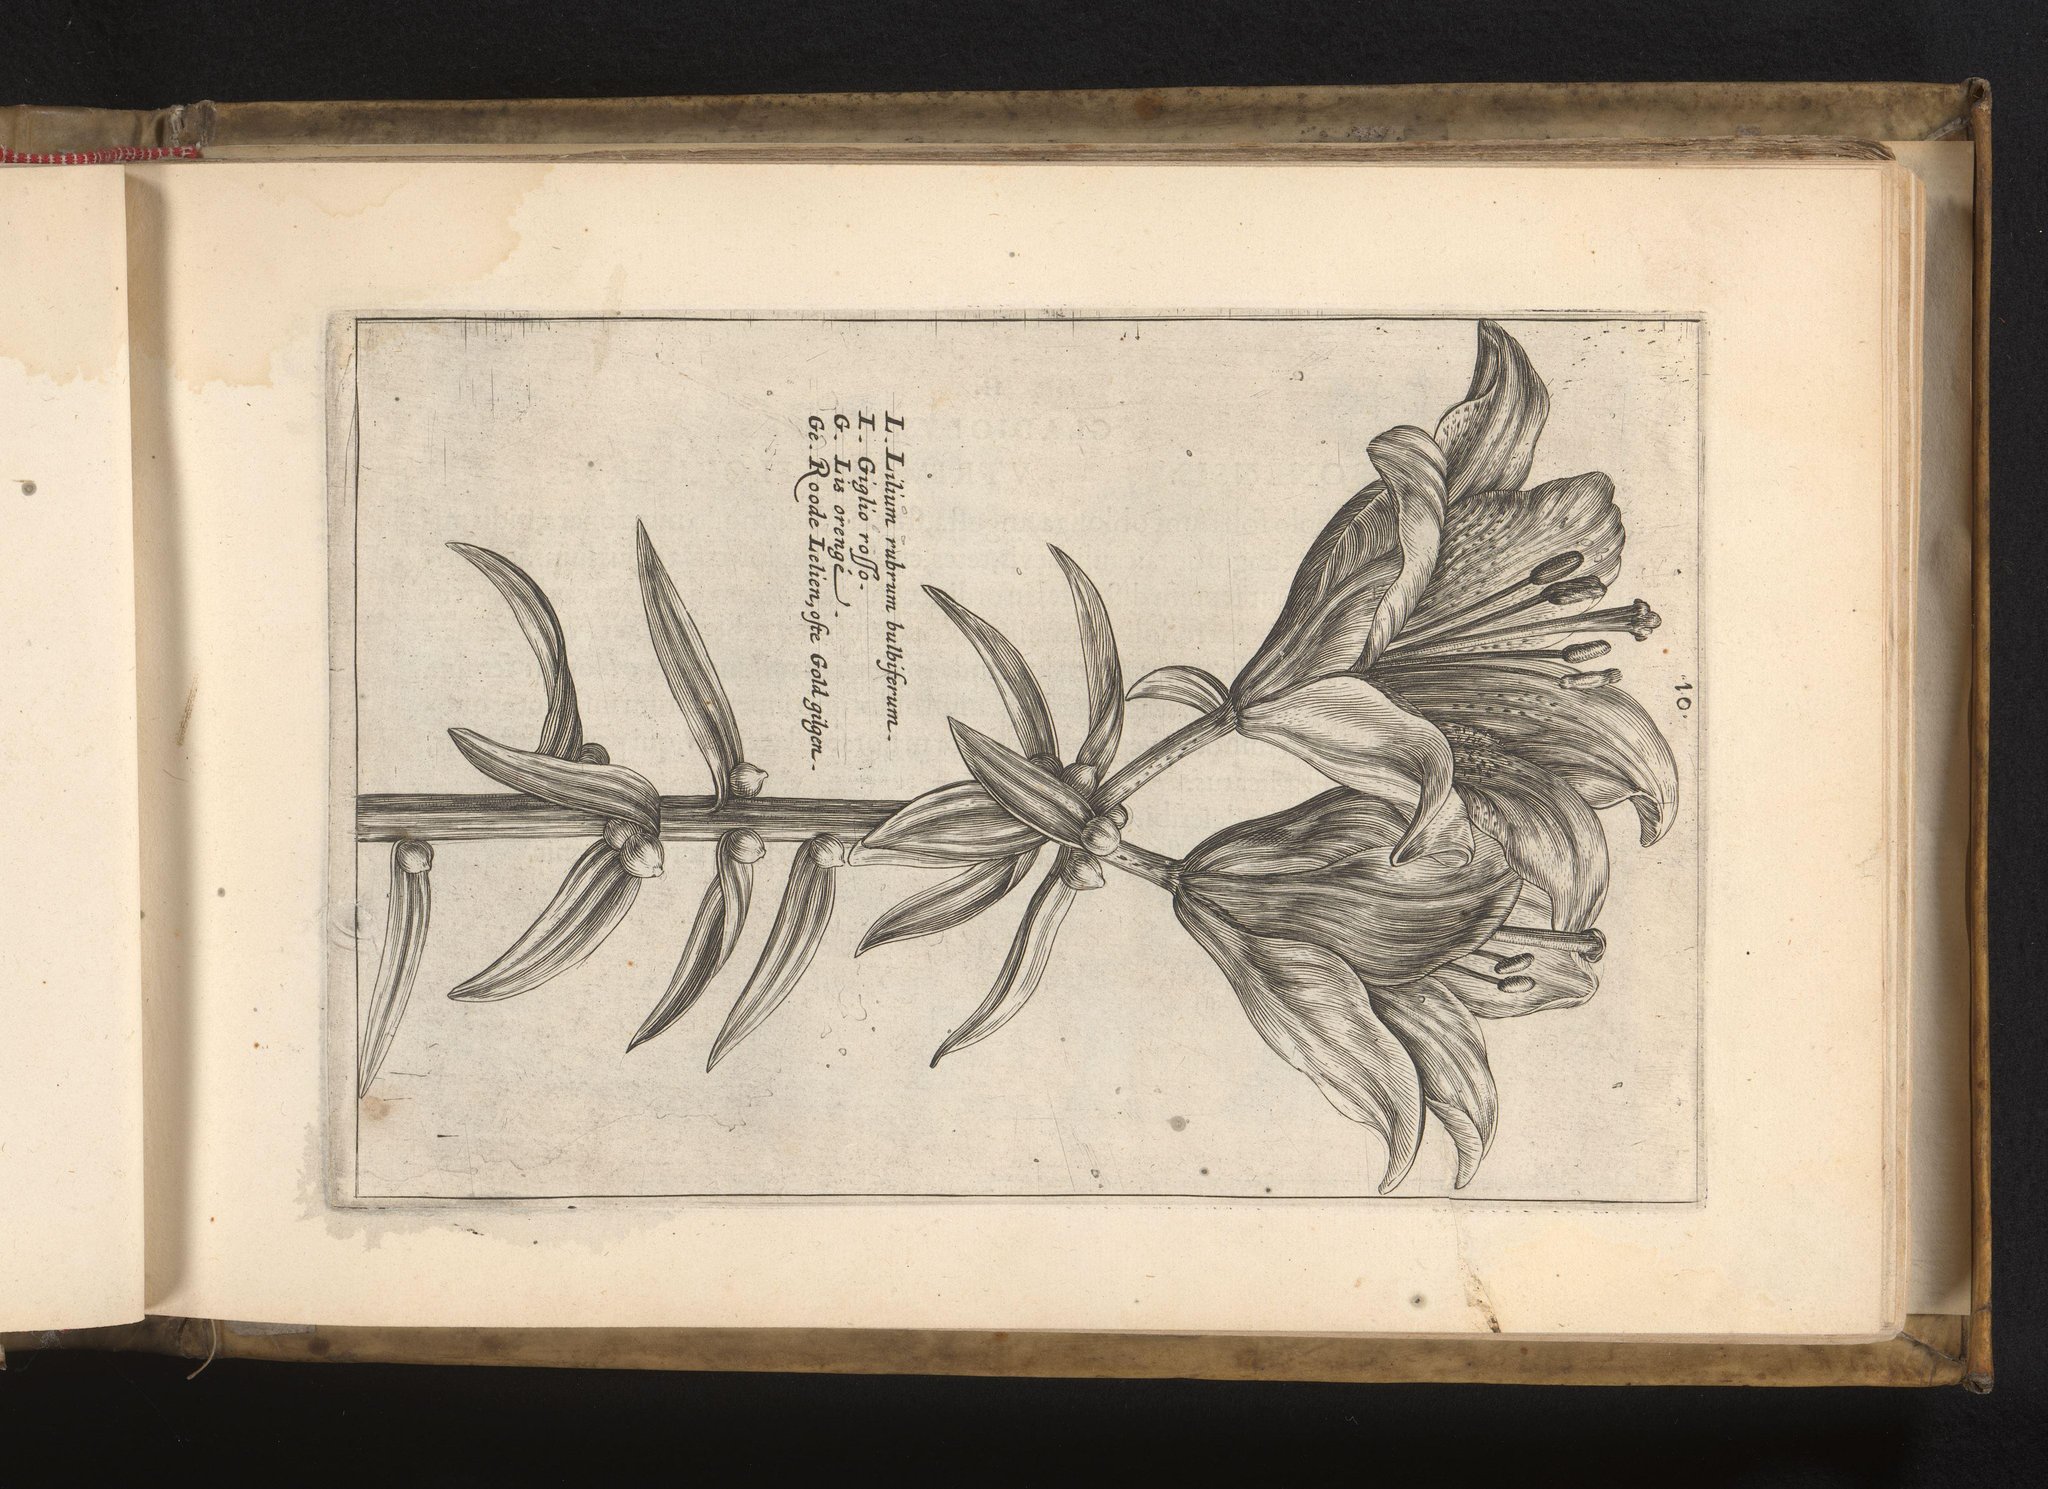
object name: print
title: Bloementuin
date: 1617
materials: paper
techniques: engraving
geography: utrecht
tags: flowers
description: Prent uit: Passe, Crispijn van de (II). Hortus floridus in quo rariorum & minus vulgarium florum icones ad vivam veramque formam. Arnhem: Johannes Janssonius, 1617.